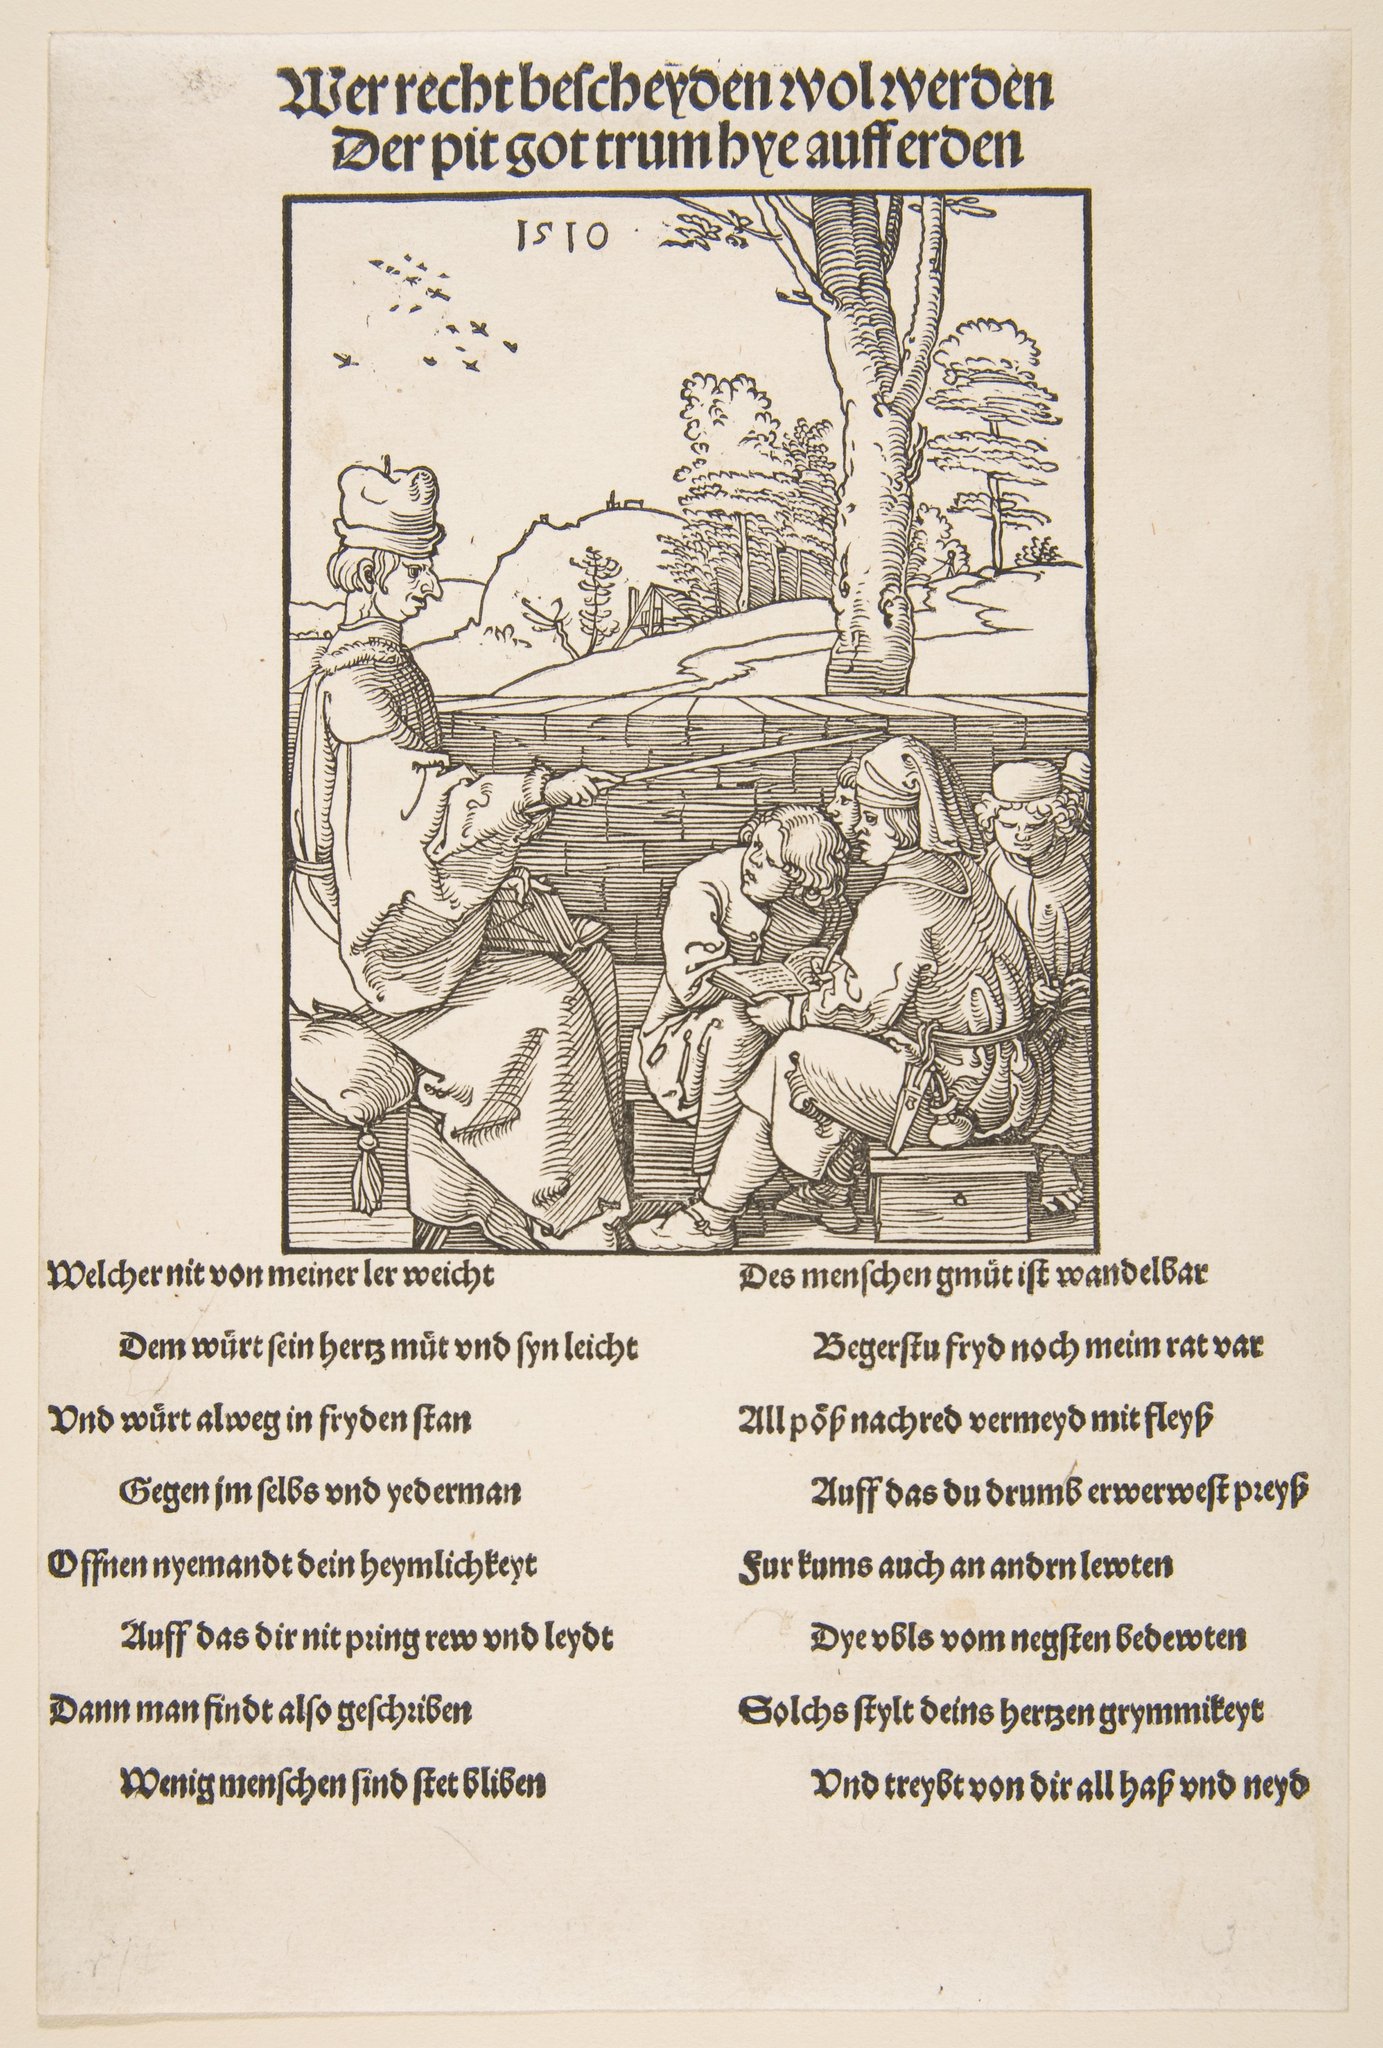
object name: print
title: The Schoolmaster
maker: albrecht dürer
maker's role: artist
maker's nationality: german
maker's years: 1471-1528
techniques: woodcut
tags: students,teachers